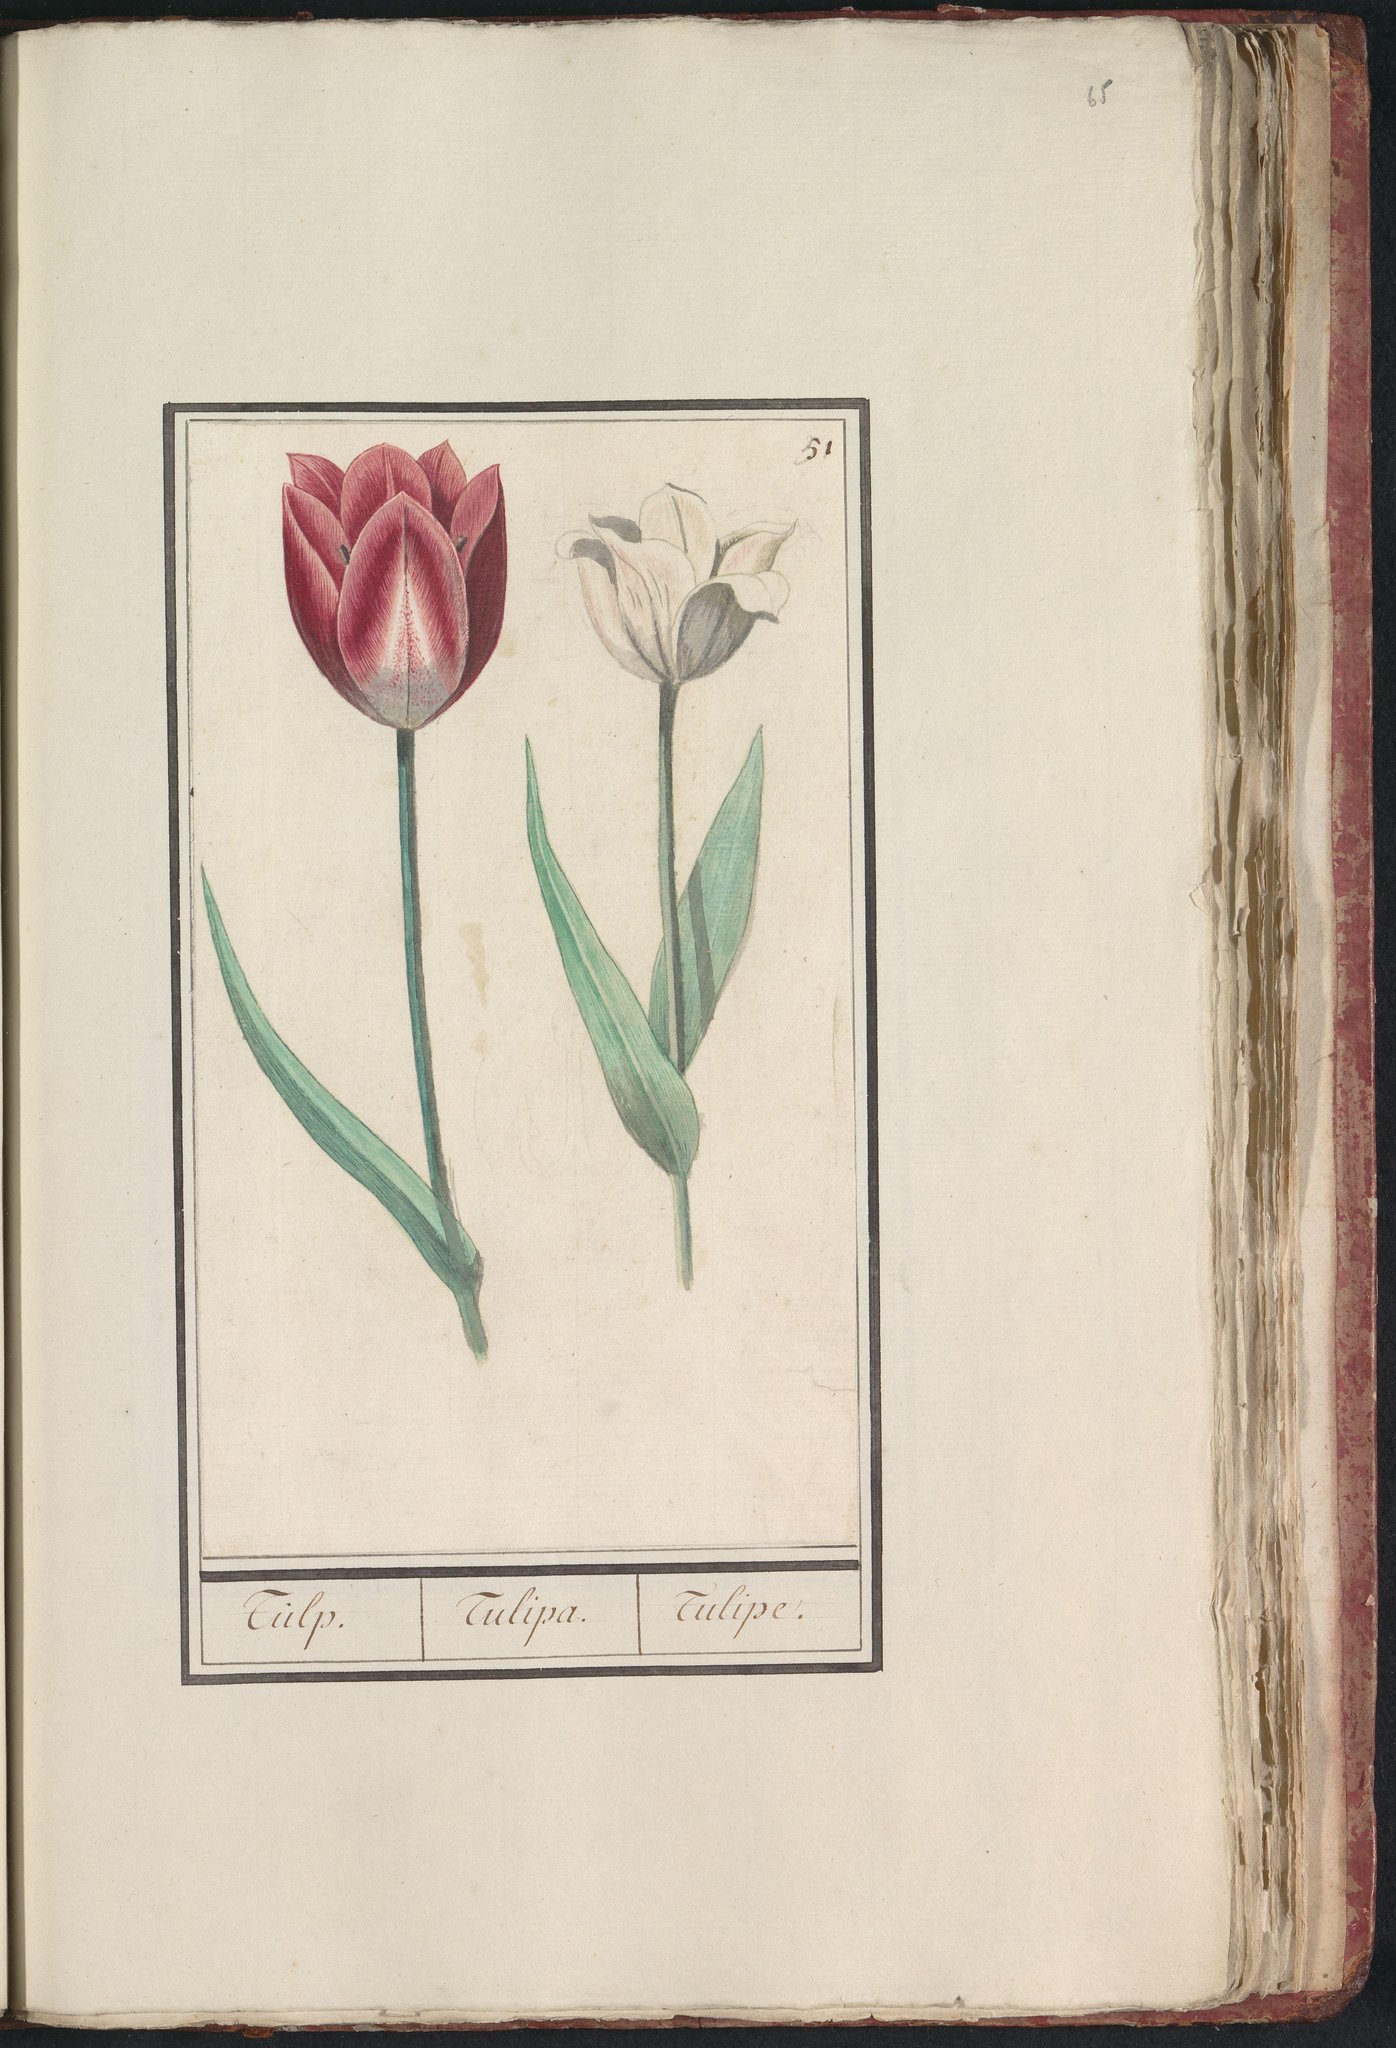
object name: drawing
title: Tulp (Tulipa)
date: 1596-1610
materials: chalk, paint, paper, watercolor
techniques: brush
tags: flowers: tulip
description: Rood-witte en een witte tulp. Genummerd rechtsboven: 51. Onderdeel van het eerste album met tekeningen van bloemen en planten. Achtste van twaalf albums met tekeningen van dieren, vogels en planten bekend rond 1600, gemaakt in opdracht van keizer Rudolf II. Met toelichting in Nederlands, Latijn en Frans.